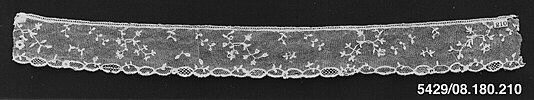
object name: fragment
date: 1767-1800